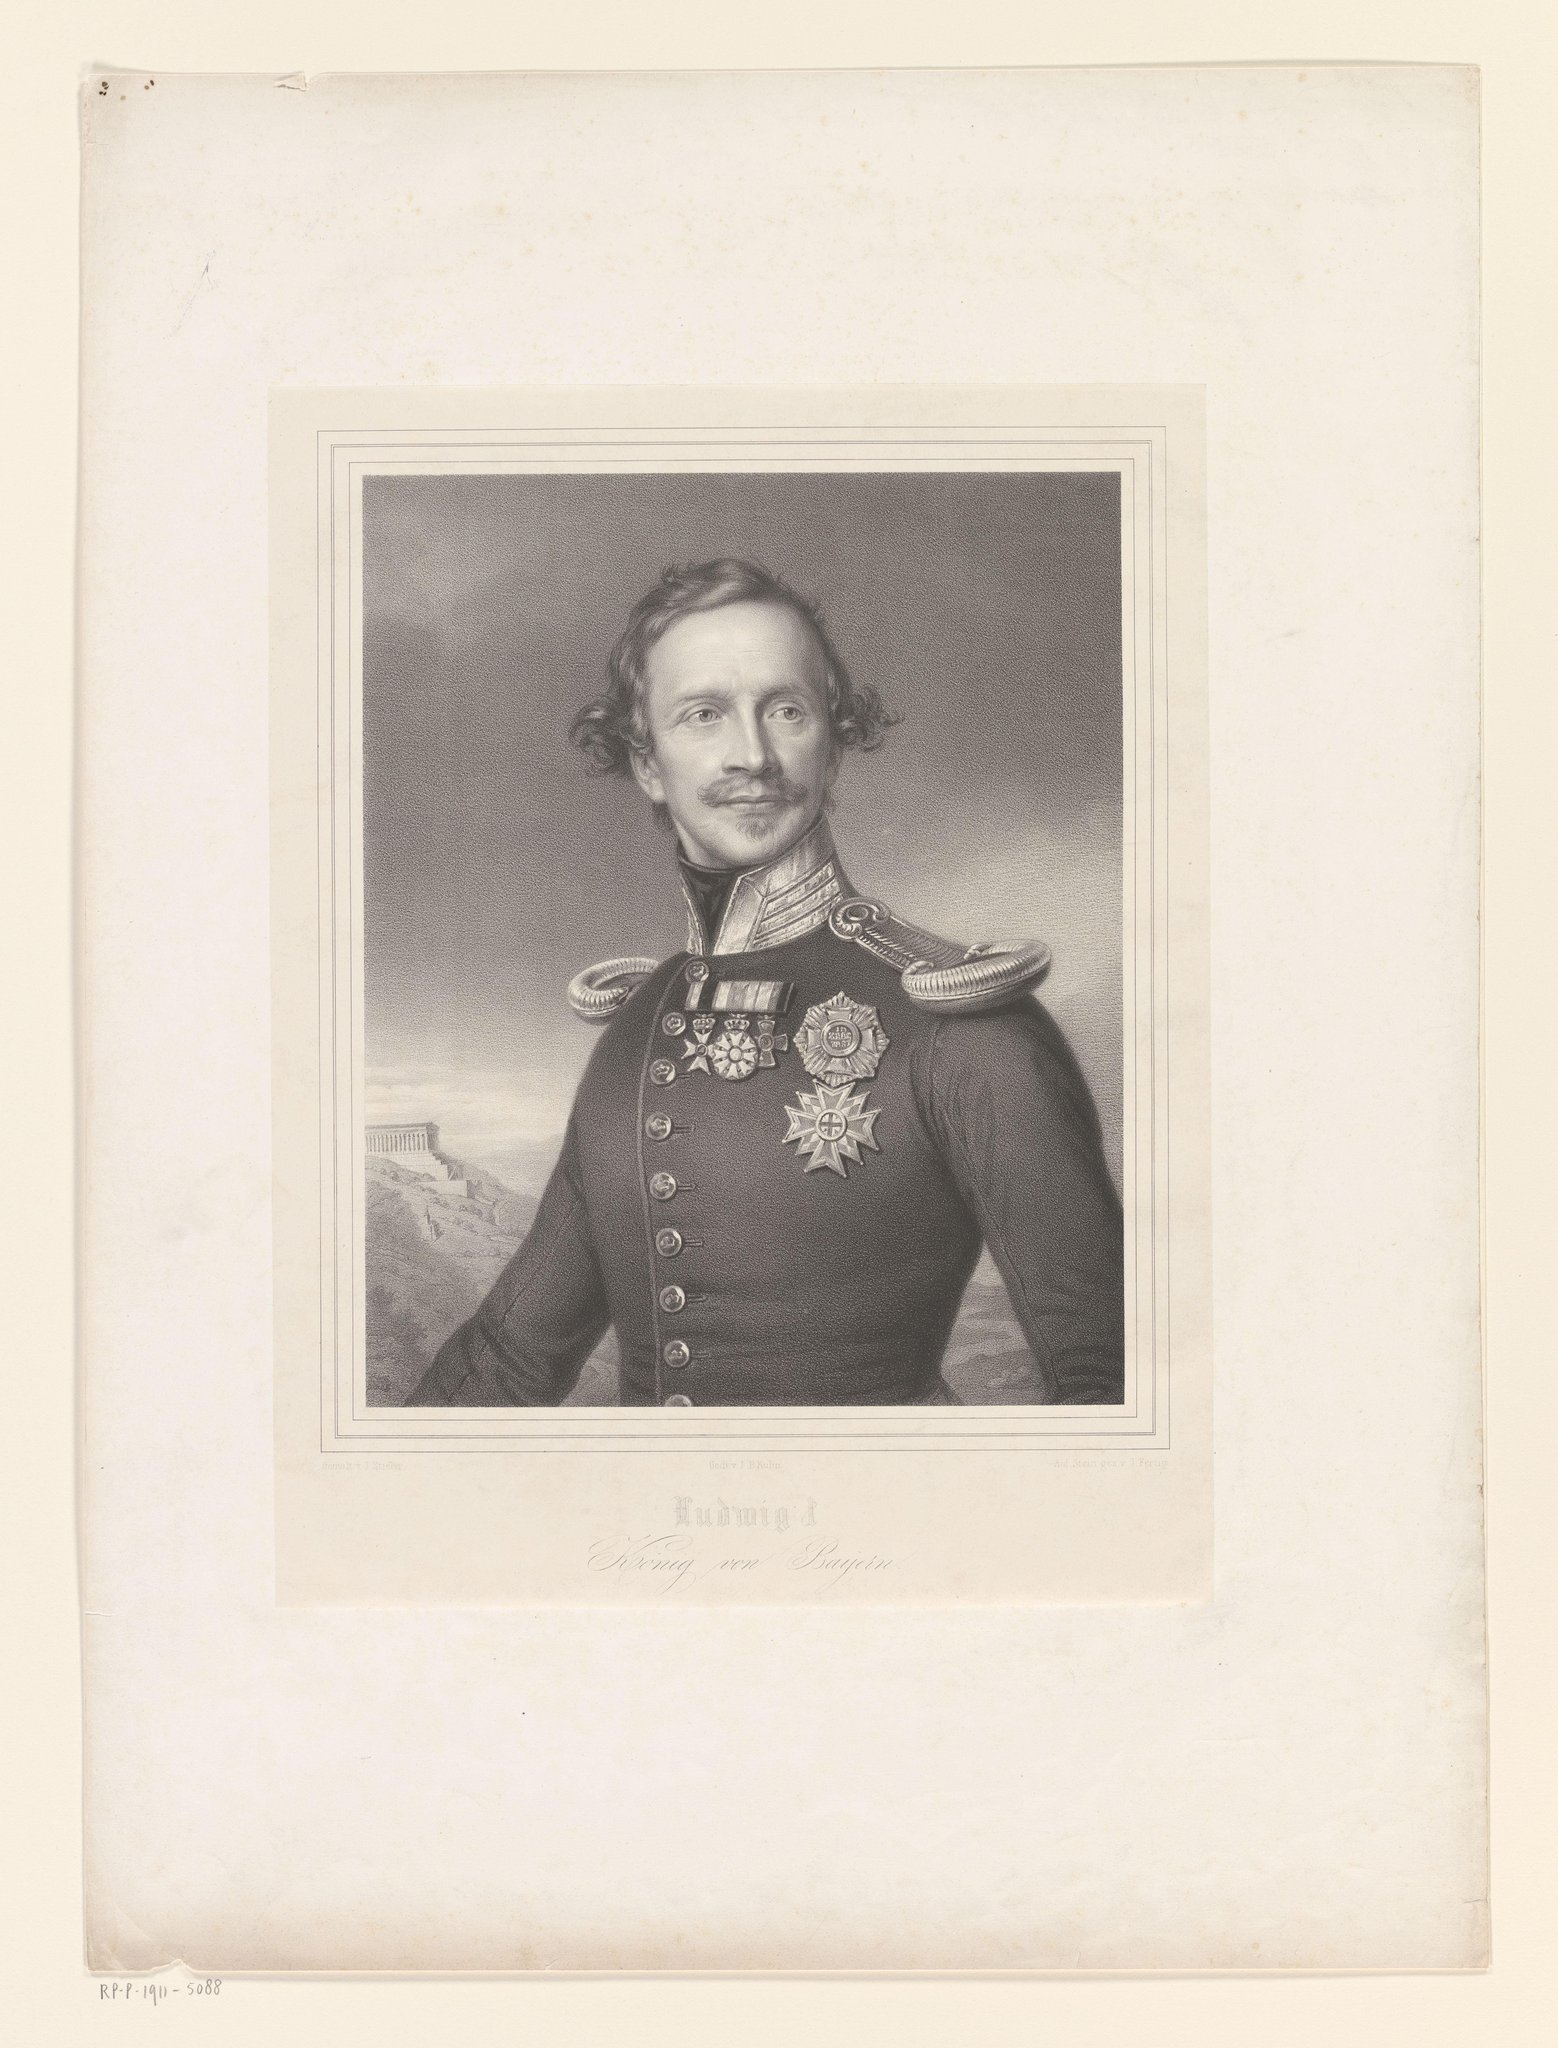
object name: print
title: Ludwig I, König von Bayern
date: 1819-1858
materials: paper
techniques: lithograph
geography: munich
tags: lodewijk i (koning van beieren), adult man, historical persons, beard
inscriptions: collector's mark: Lugt 2228